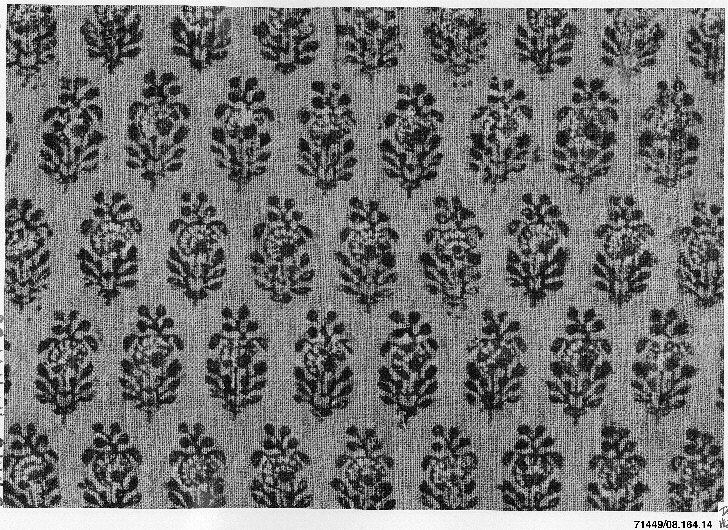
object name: panel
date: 1801-1900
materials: cotton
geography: iran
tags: flowers,leaves